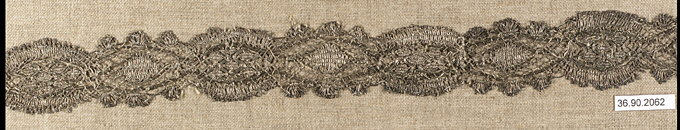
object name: piece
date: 1801-1900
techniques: lace